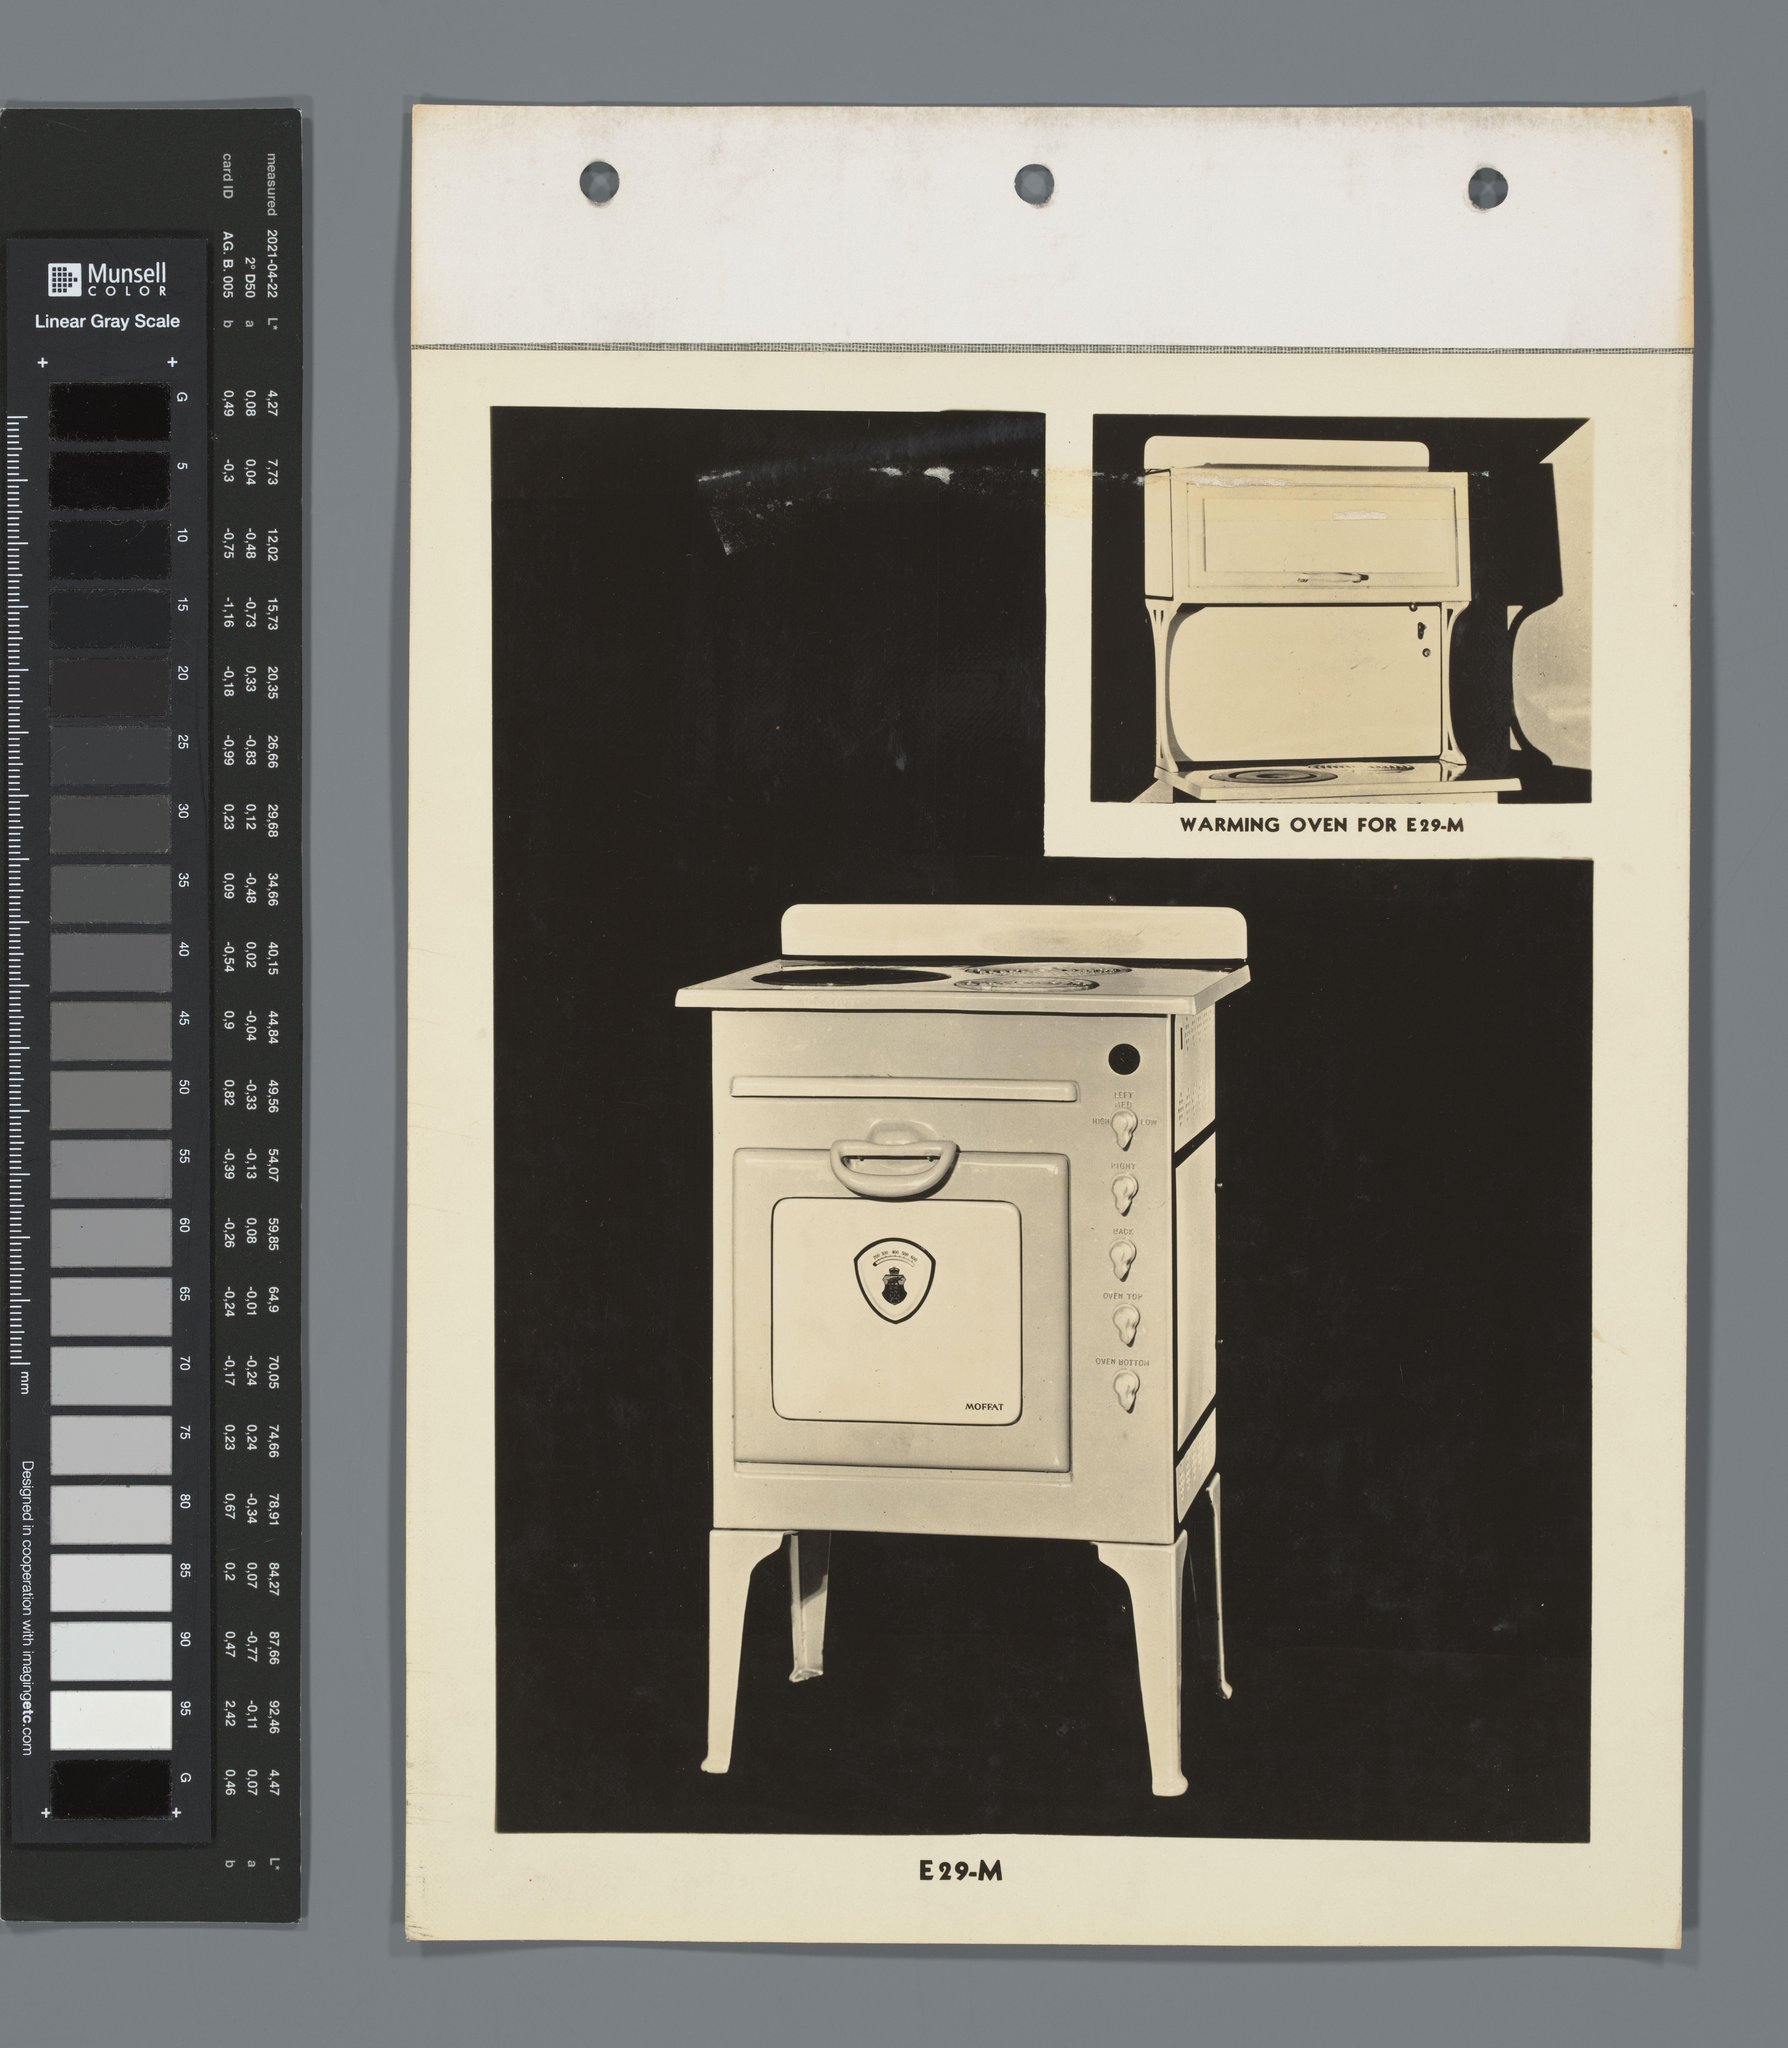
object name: photograph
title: Foto van Moffat ovens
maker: Anonymous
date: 1935-1940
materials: paper, photographic support, textile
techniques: gelatin silver print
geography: canada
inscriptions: inscription: ‘WARMING OVEN FOR E 29-M’, label: ‘FROM PUBLIC UTILITIES COMMISSION E28M. Electric Light Department NAPANEE, ONTARIO To RANGE. H.Shelf. WARM Closet. Std - $7400 C - $7850 - $875 $17.25 Spec - 8050. $9.00 $ 17.50 Via Date’, inscription: ‘E 29-M’